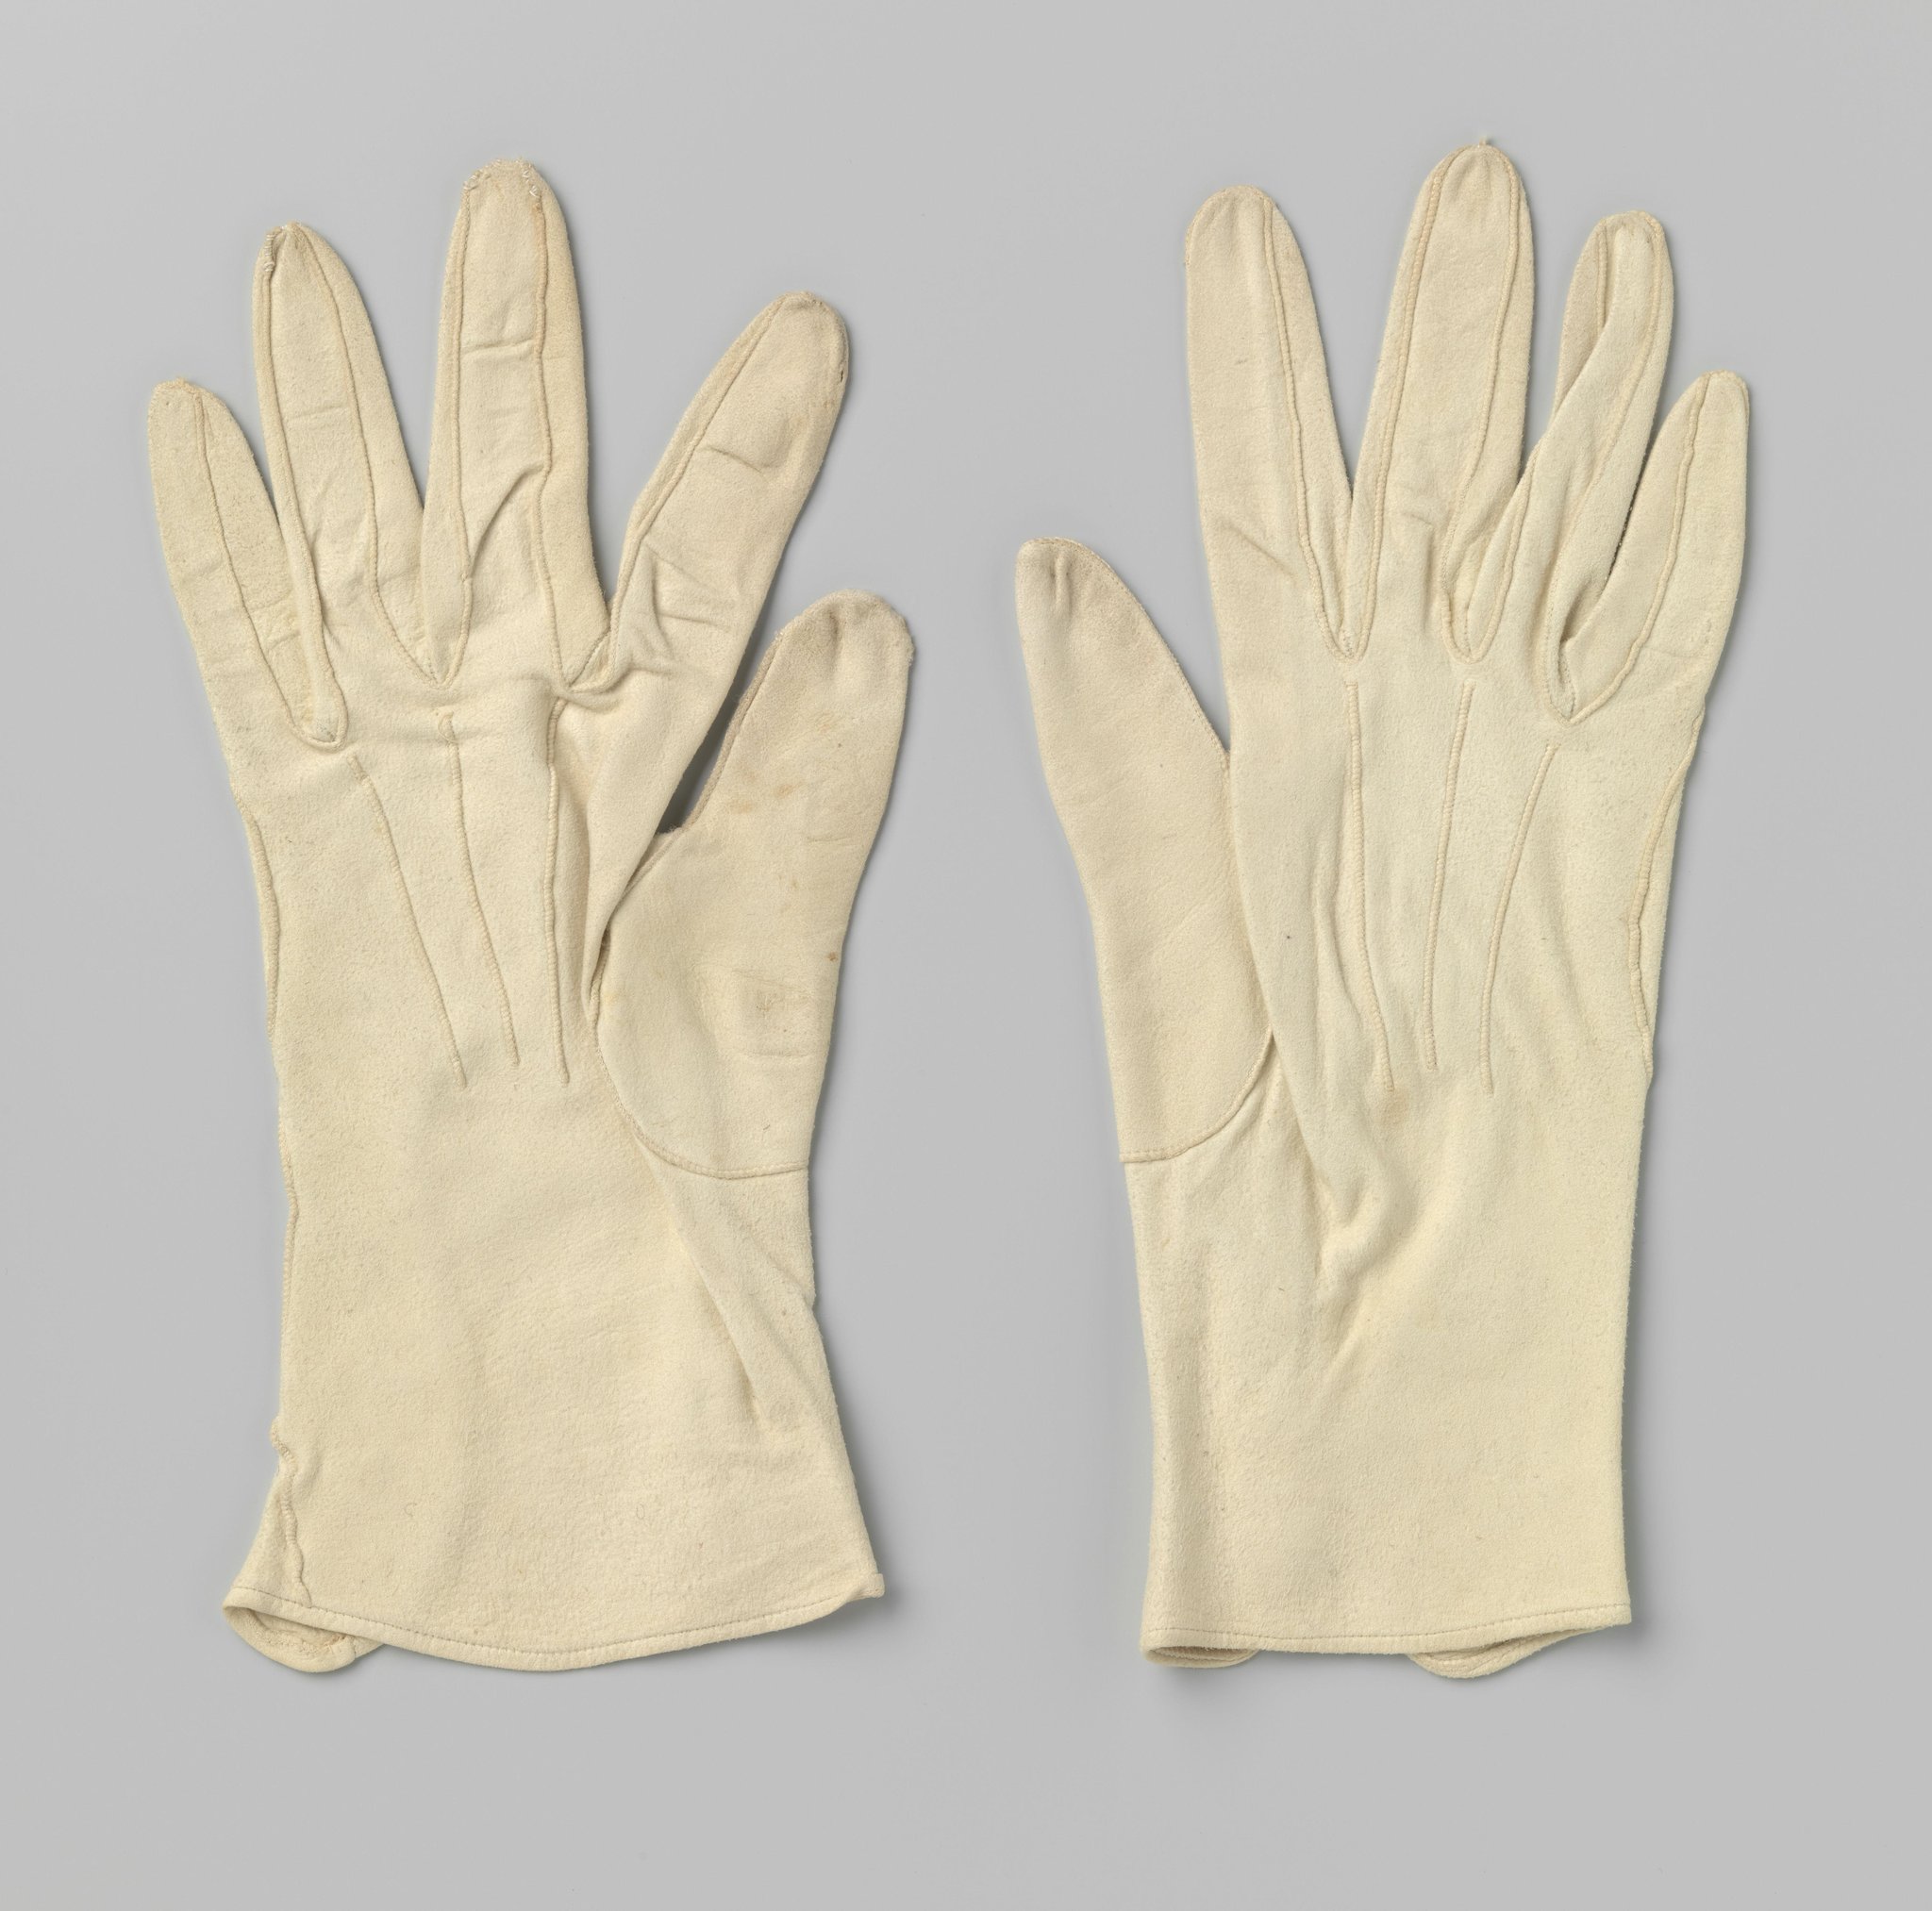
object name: clothing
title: Handschoen van wit zeemleer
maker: Anonymous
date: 1900-1915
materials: leather, plastic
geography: western europe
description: Linker handschoen van wit zeemleer. Op de rug versierd met drie gestikte verdikte koorden. Aan binnenzijde pols voorzien van drie parelmoerkleurige knopen.